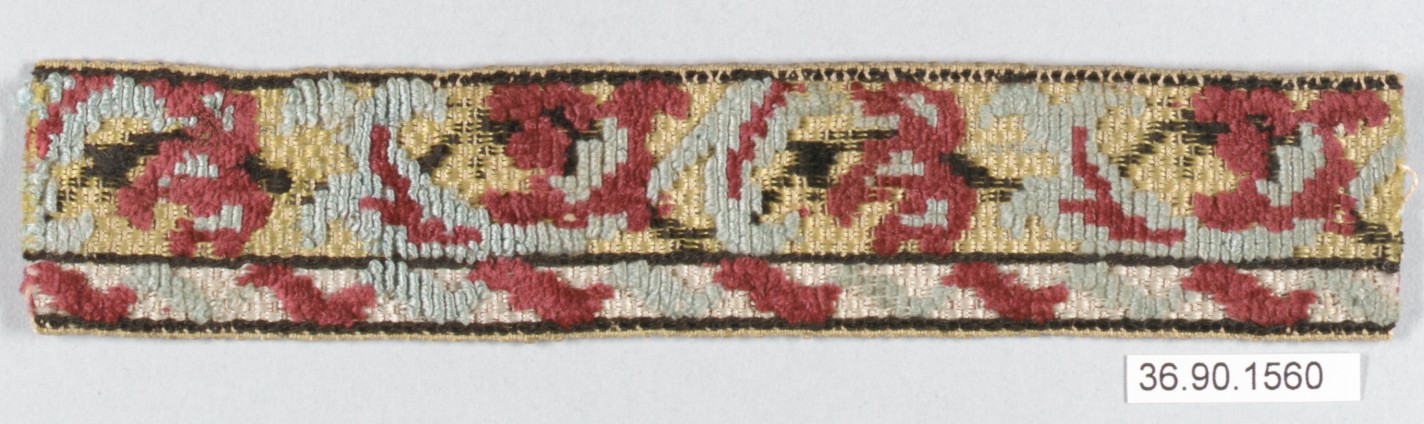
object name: galloon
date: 1701-1900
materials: silk